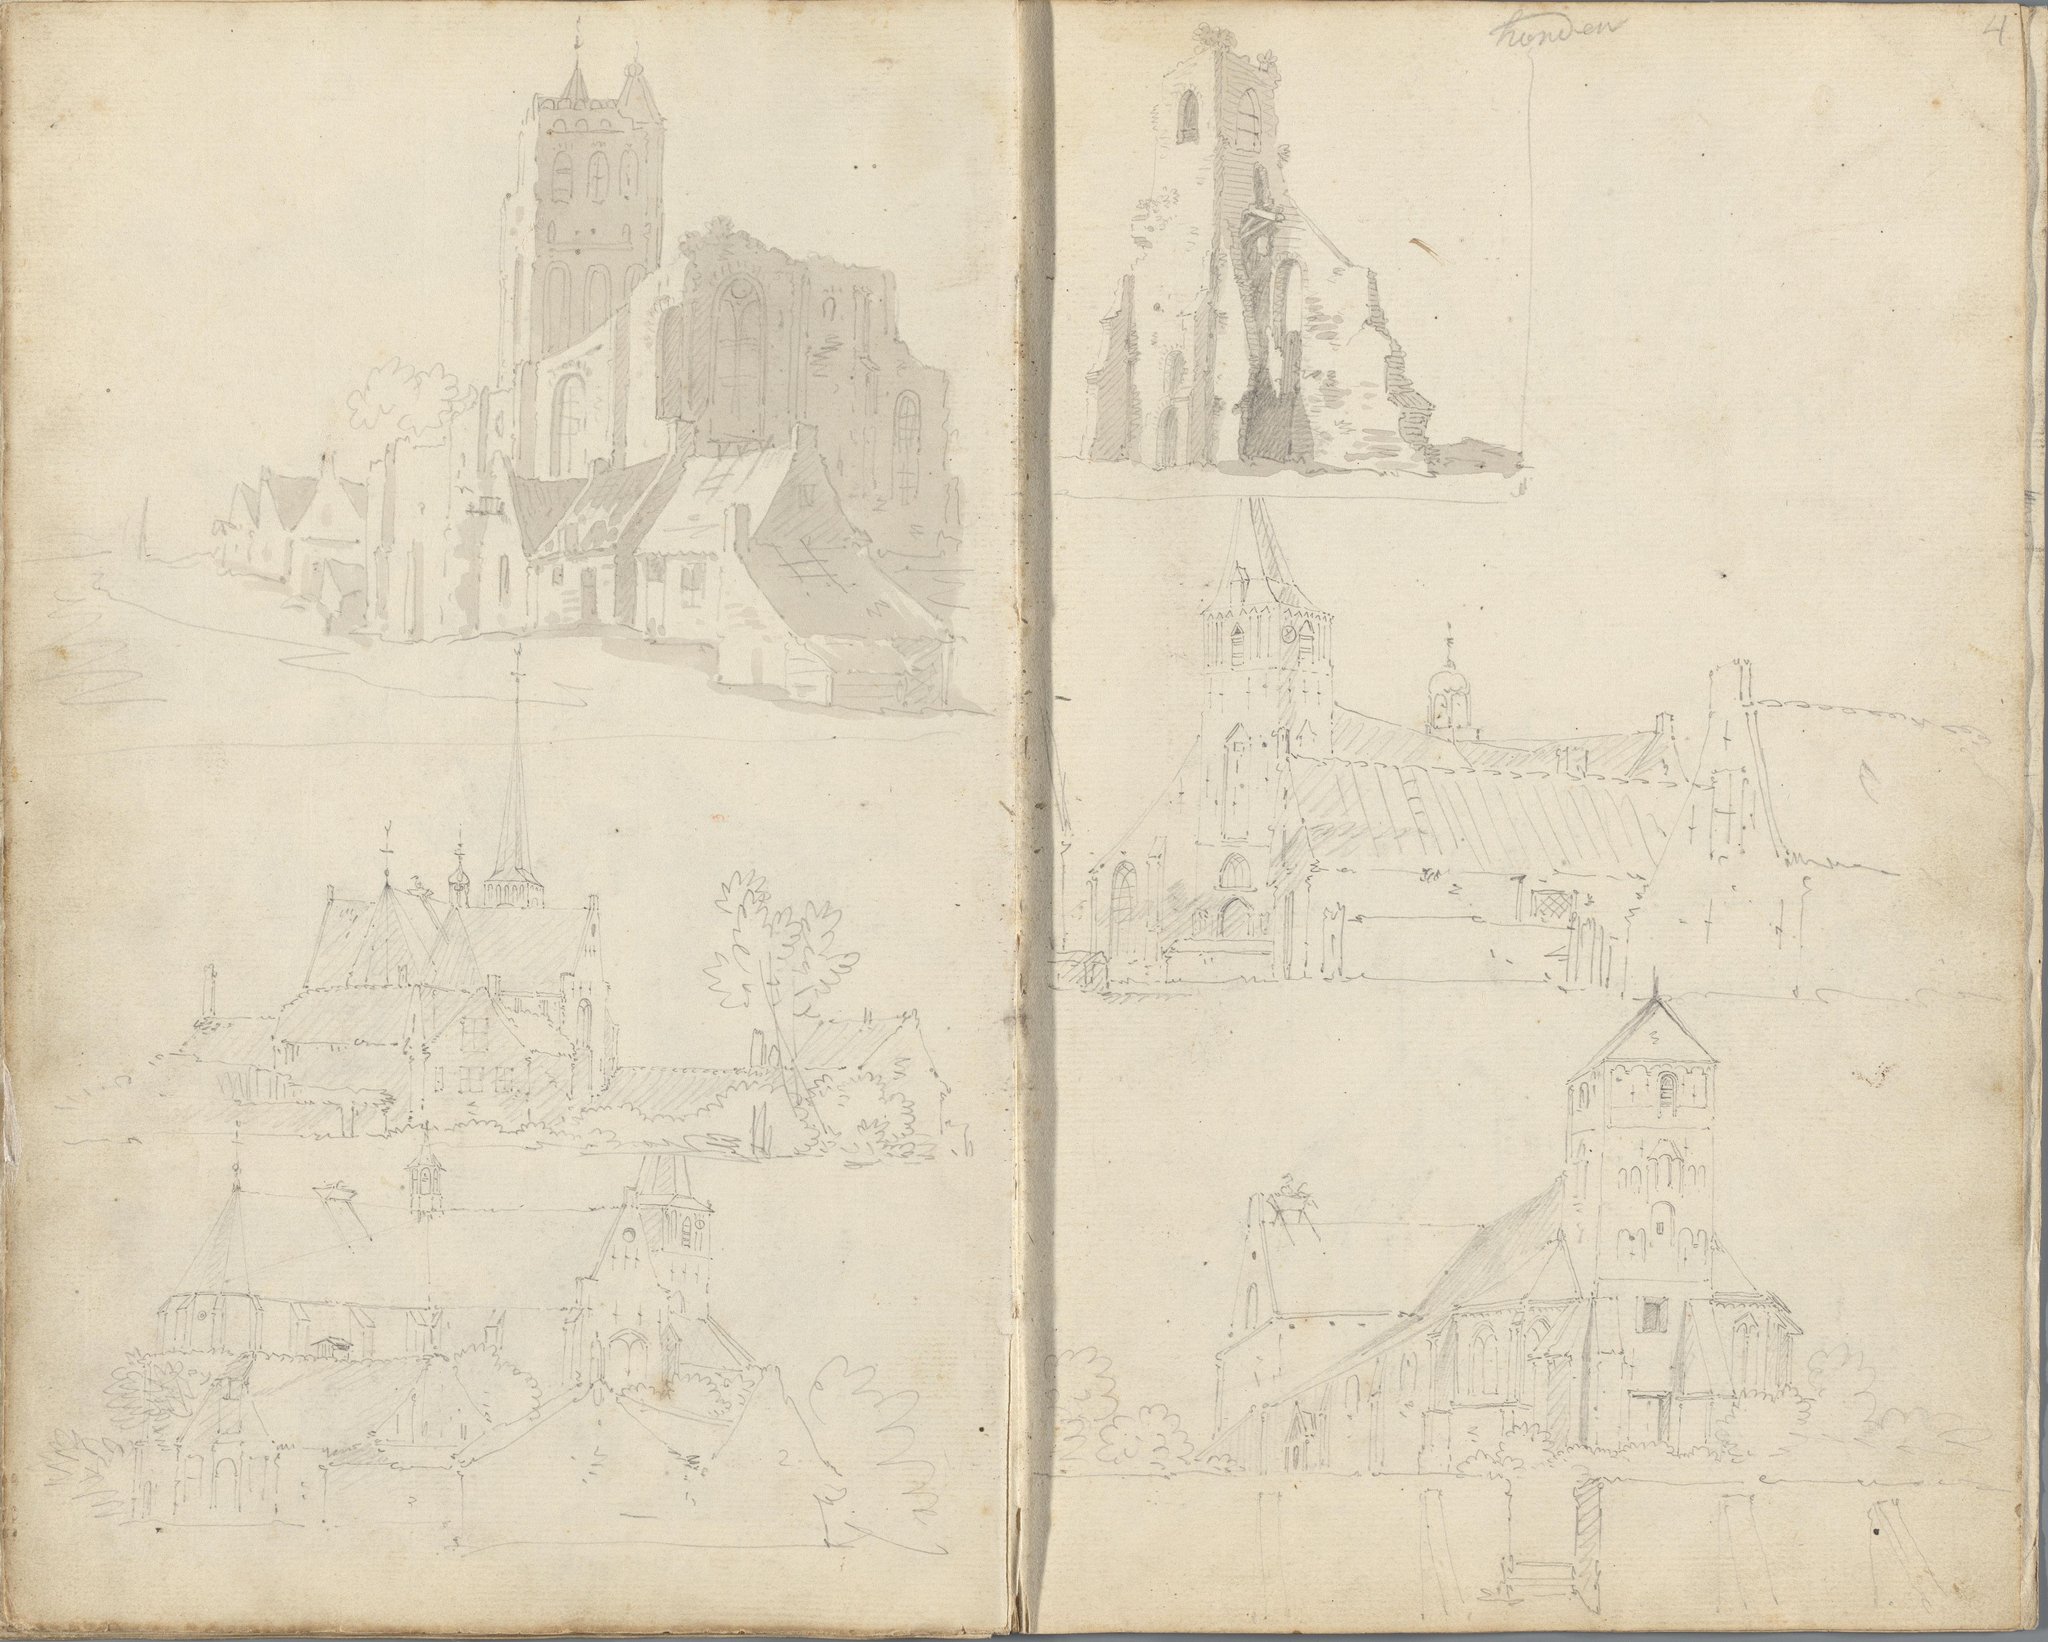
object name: sketchbook leaf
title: Kerken en een ruïne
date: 1780-1800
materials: ink, paper, pencil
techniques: brush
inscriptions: inscription: ‘4’, inscription: ‘Londen’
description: Blad 12 recto uit een schetsboek met 17 bladen.